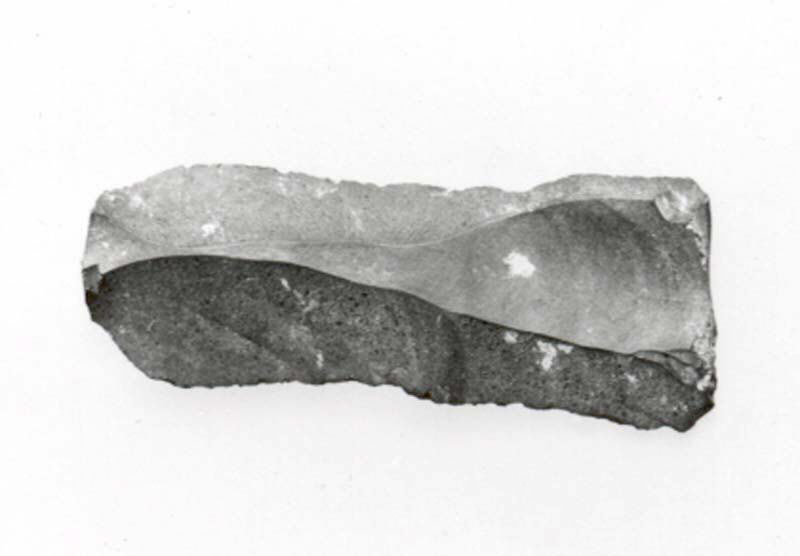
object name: tool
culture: iranian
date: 5000-2001 BCE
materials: stone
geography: iran